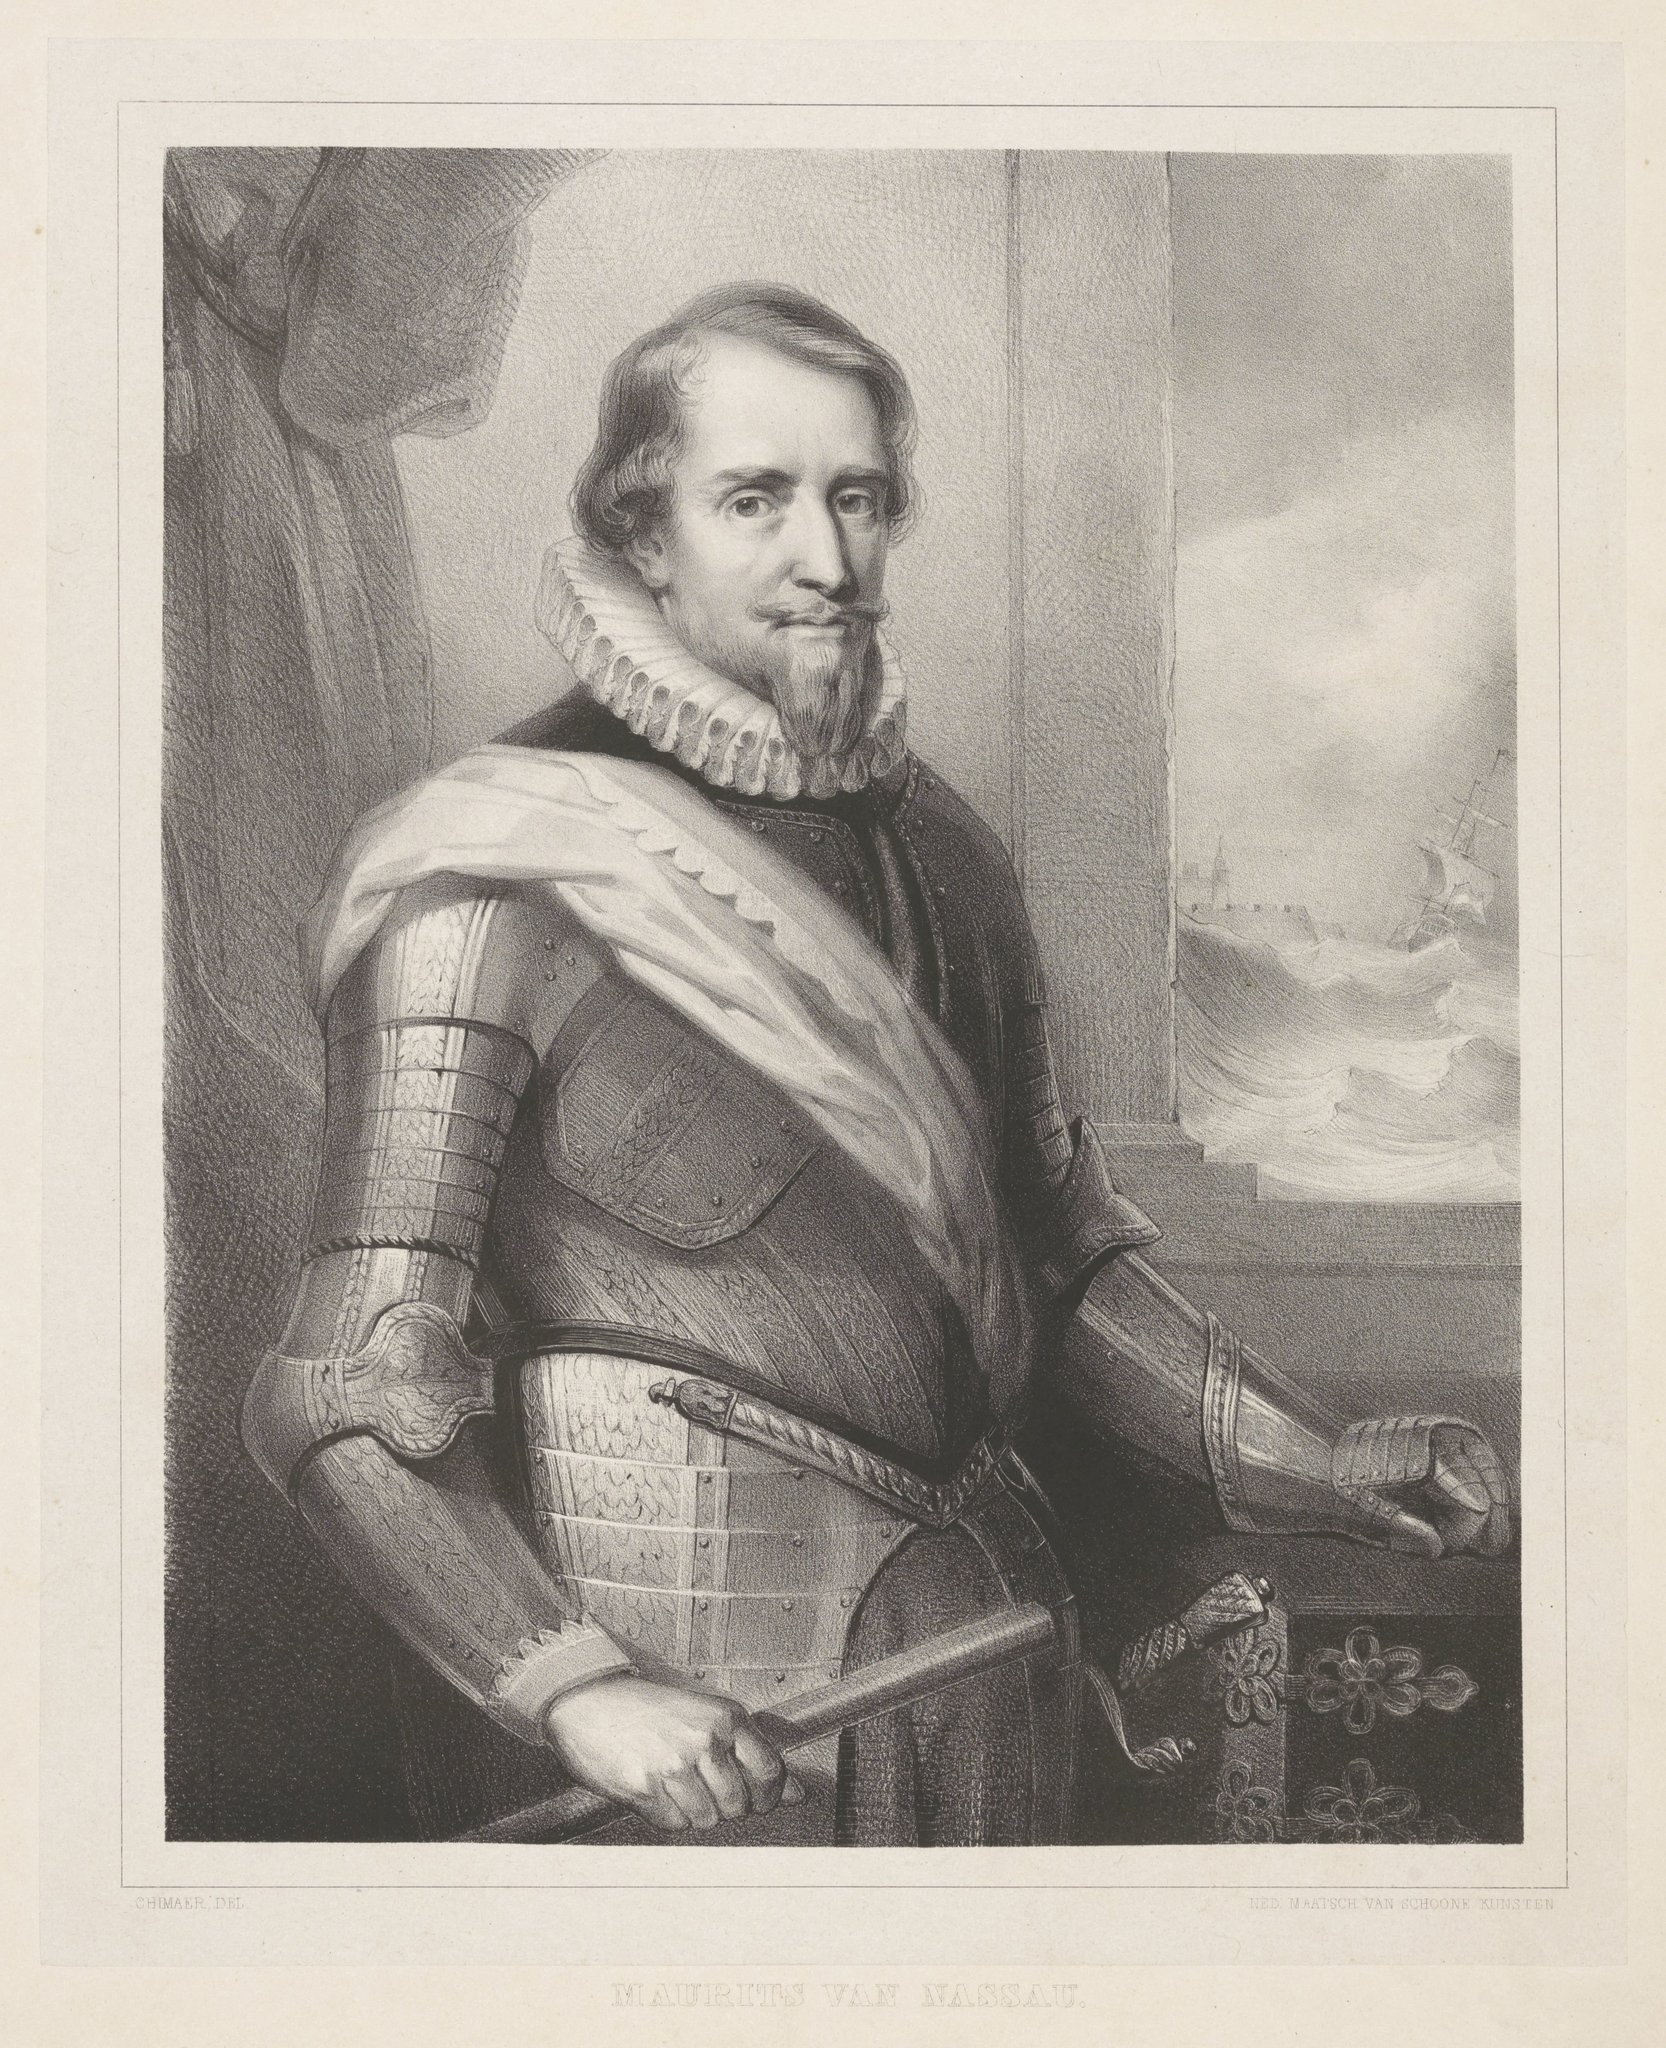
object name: print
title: Portret van Maurits, prins van Oranje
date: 1840-1843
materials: paper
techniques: lithograph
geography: the hague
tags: the hague, maurice (prince of orange)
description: De hier vermelde titel verwijst naar de hoogst verkregen titel van de geportretteerde, niet per se naar de titel die de geportretteerde op deze voorstelling draagt.